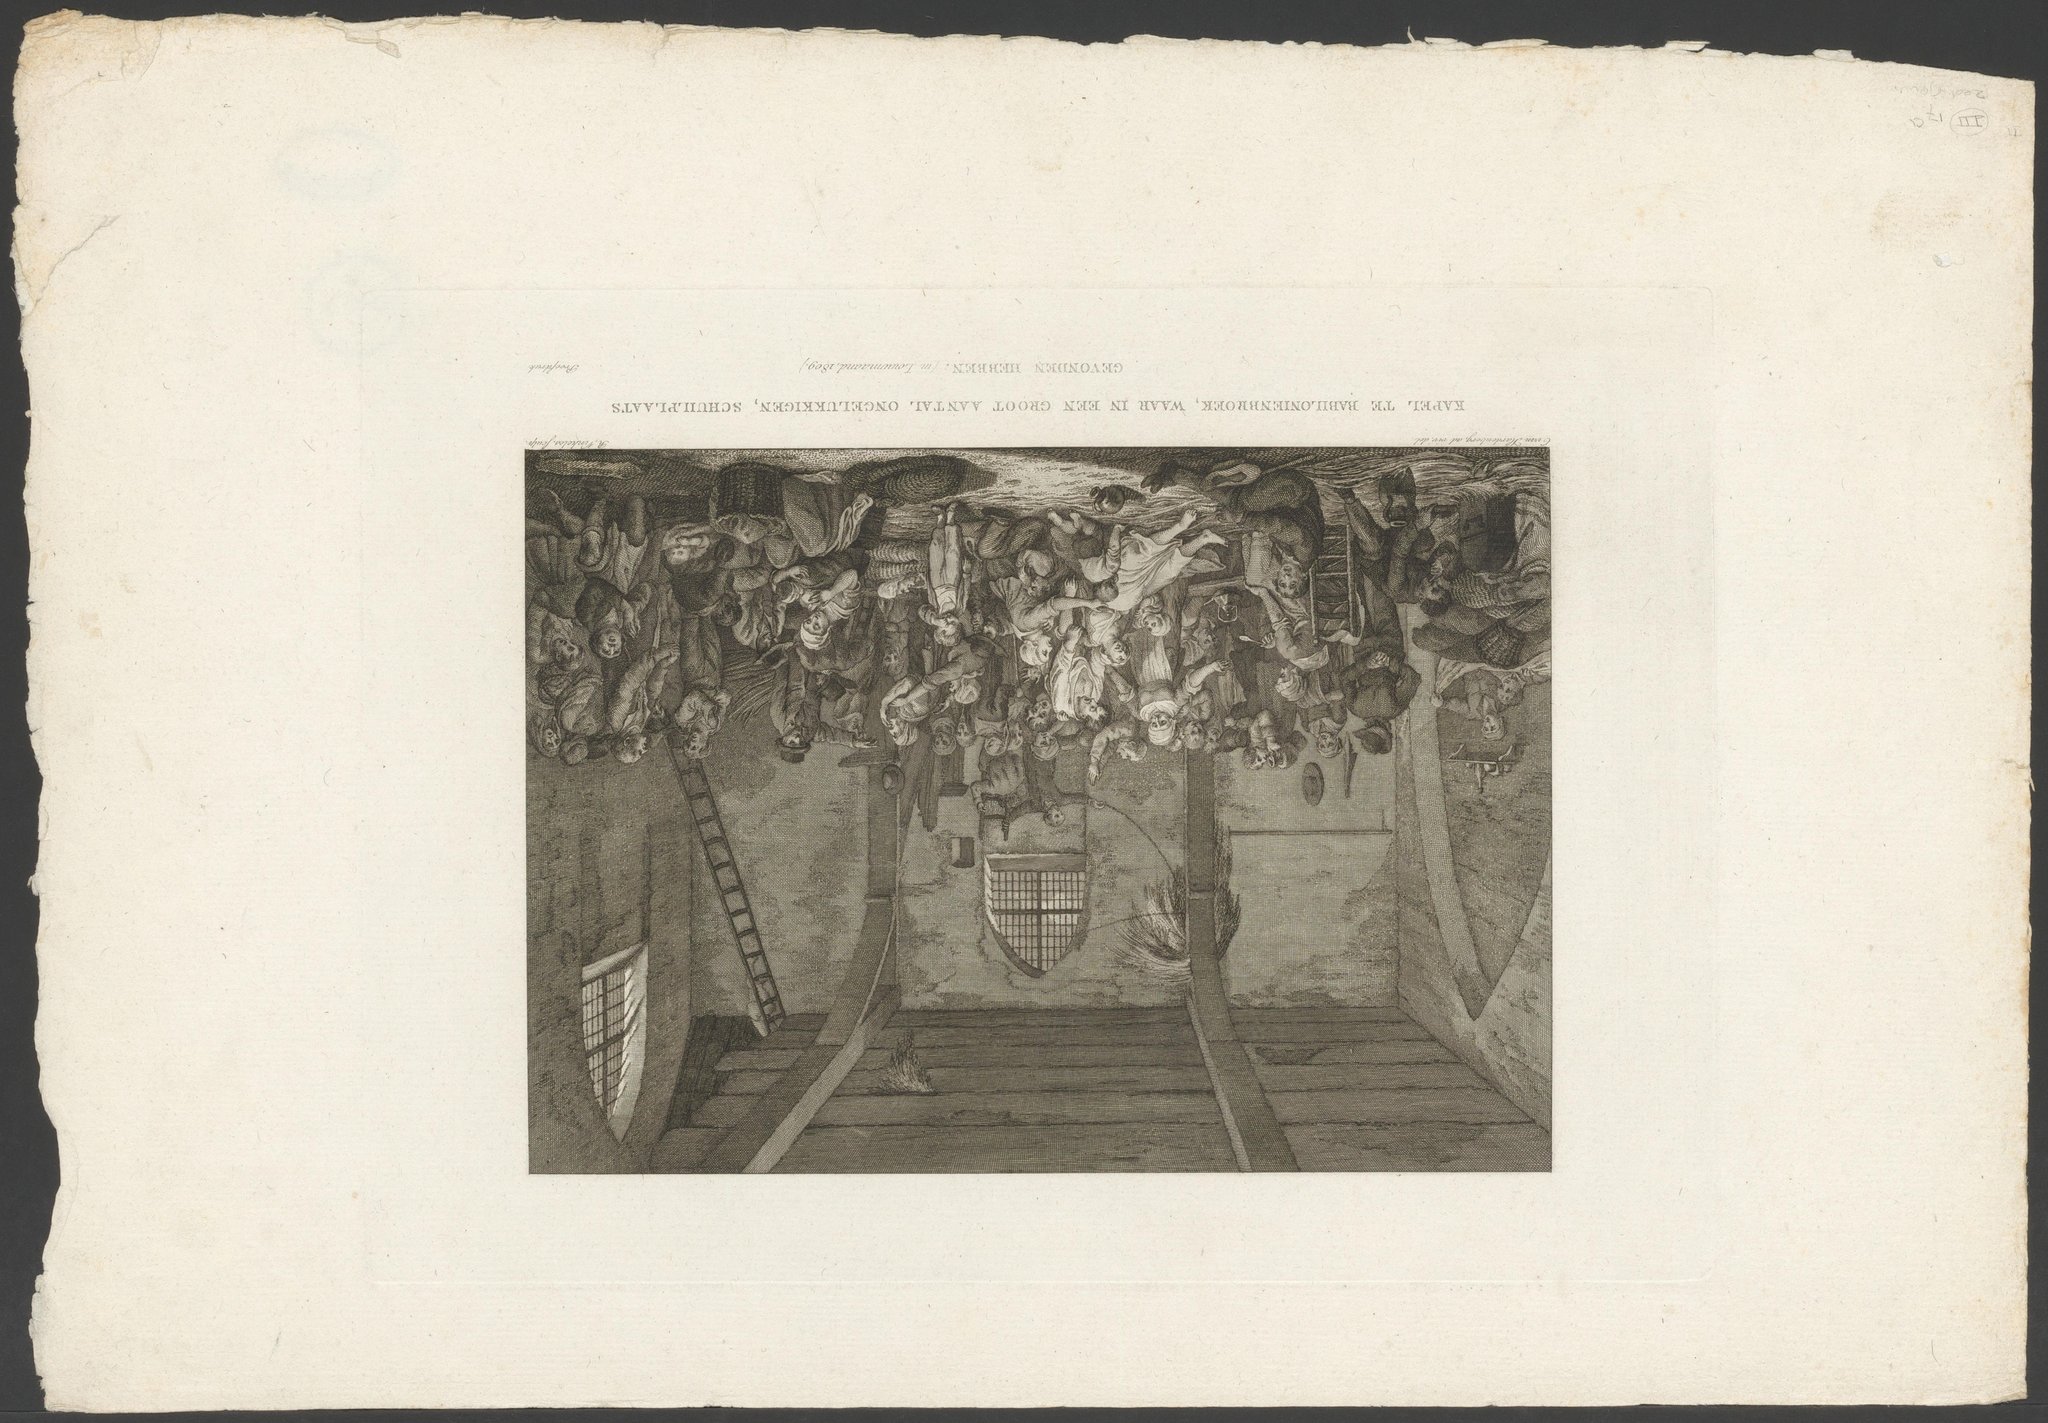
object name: print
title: Platen en kaarten behorende tot het geschiedkundig verslag der Dijkbreuken en Overstroomingen, in louwmaand MDCCCIX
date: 1809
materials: paper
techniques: engraving, etching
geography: amsterdam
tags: rescue work during a flood, dike-break, interior of church, flood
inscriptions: collector's mark: Lugt 1641, stamp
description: Prent ook gebruikt ter illustratie van: Ewijk, Hendrik. Geschiedkundig verslag der dijkbreuken en overstroomingen, langs de rivieren in het Koningrijk Holland, voorgevallen in louwmaand MDCCCIX. 3 dln. Amsterdam: Johannes Allart en Jacobus Ruys, 1809.